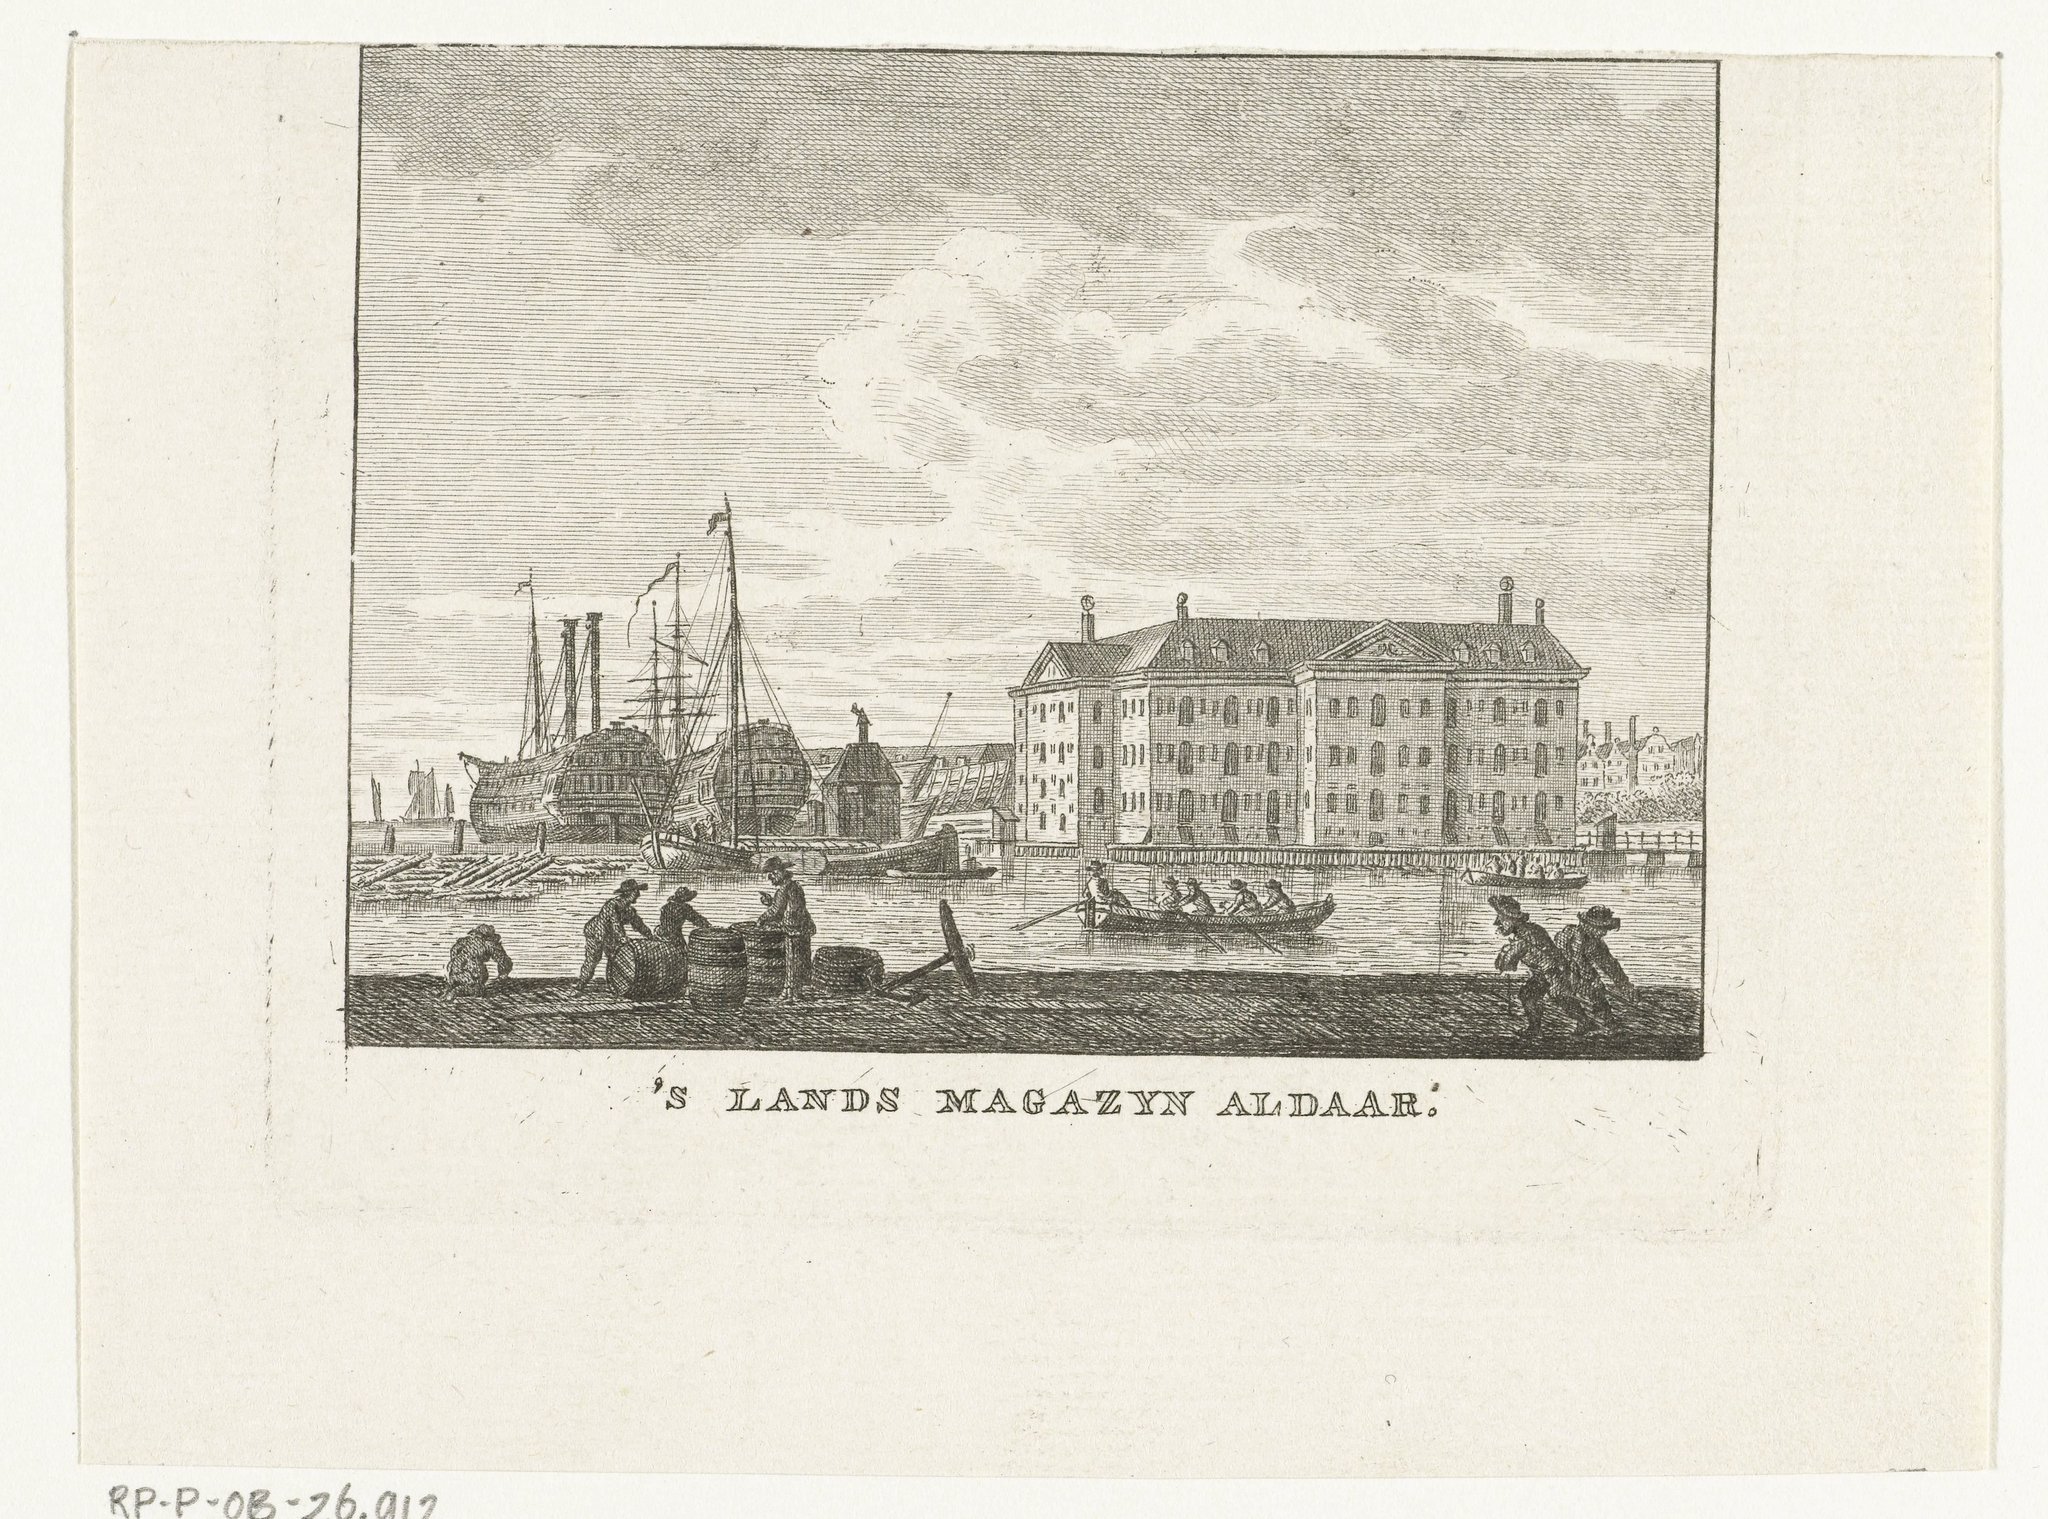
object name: print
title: 's Lands magazyn aldaar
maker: cornelis brouwer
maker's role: print maker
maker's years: 1731-1803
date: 1780-1790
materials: paper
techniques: etching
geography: netherlands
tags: harbour